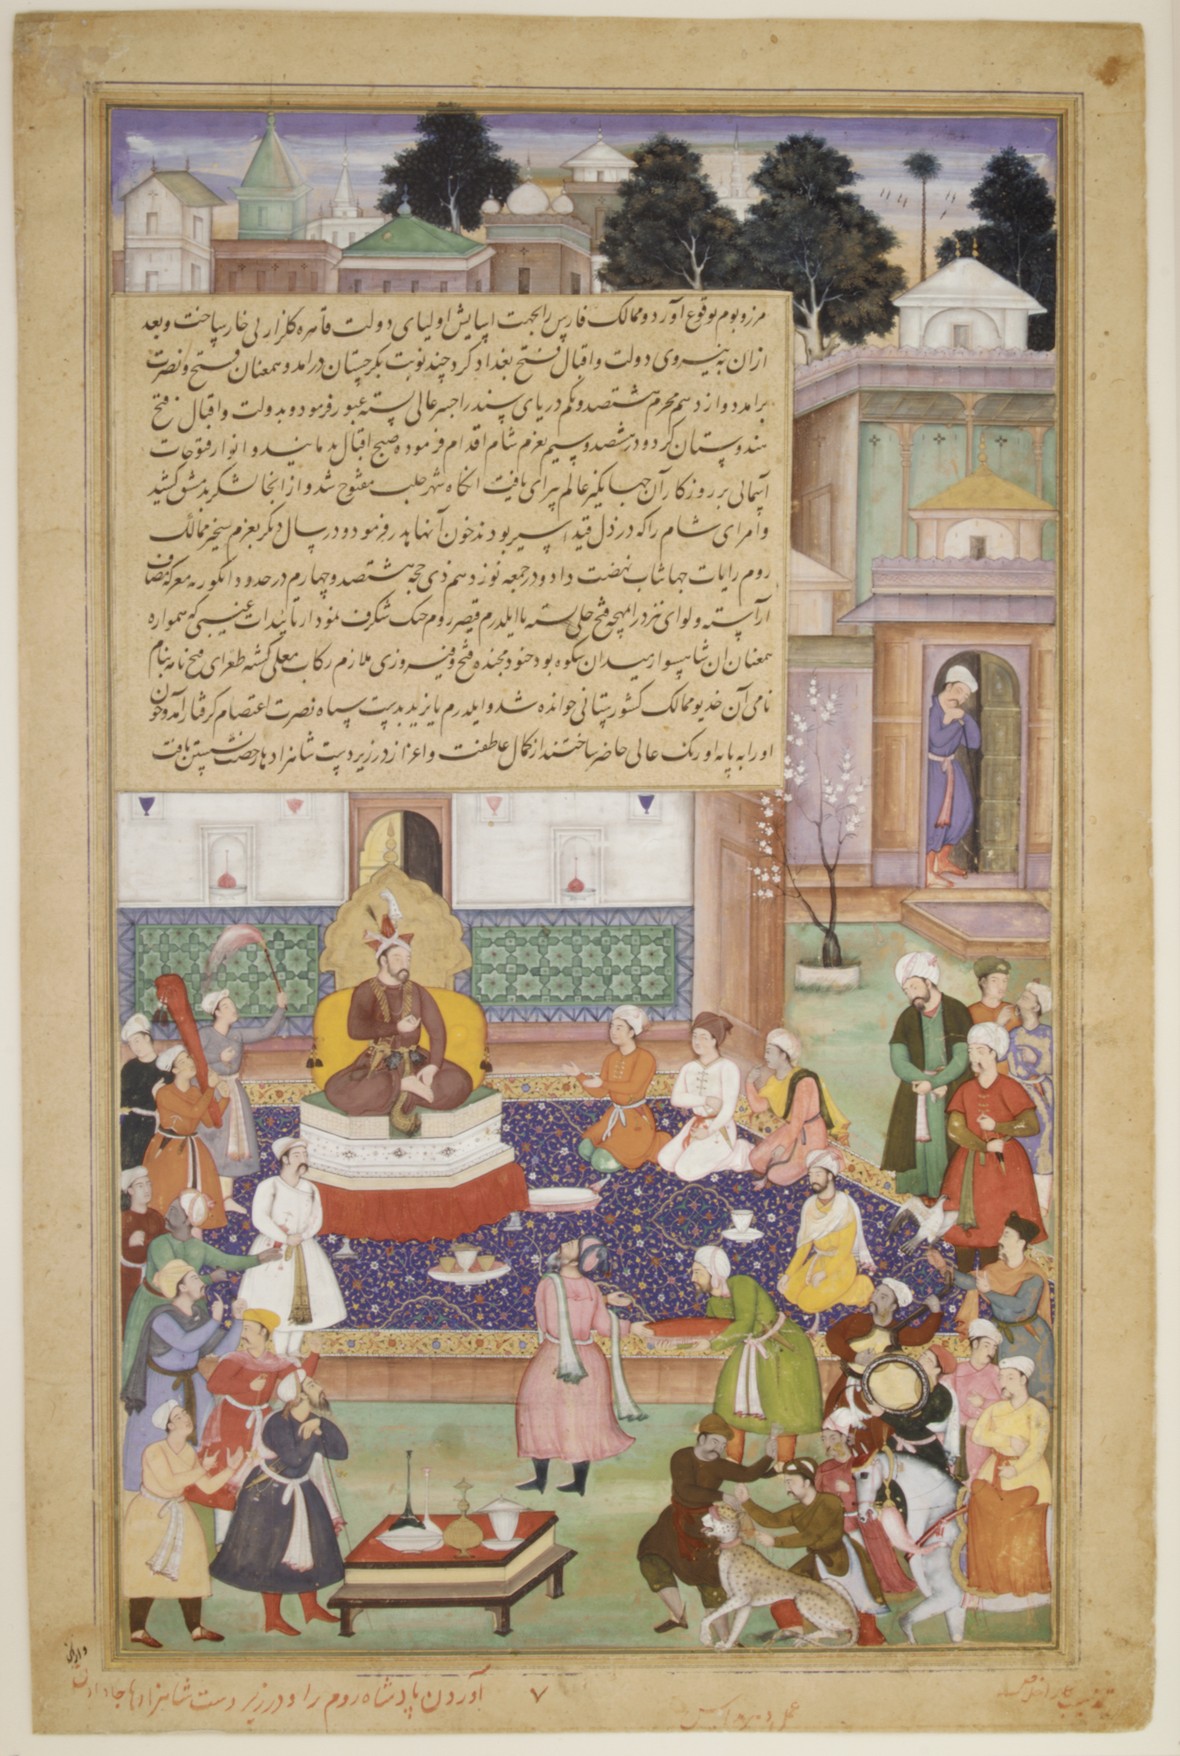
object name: folio from an illustrated manuscript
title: "Sultan Bayazid before Timur", Folio from an Akbarnama (History of Akbar)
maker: dharam das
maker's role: artist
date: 1600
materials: gold, ink, paper, watercolor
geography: pakistan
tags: animals,kings,men,cheetahs,horses